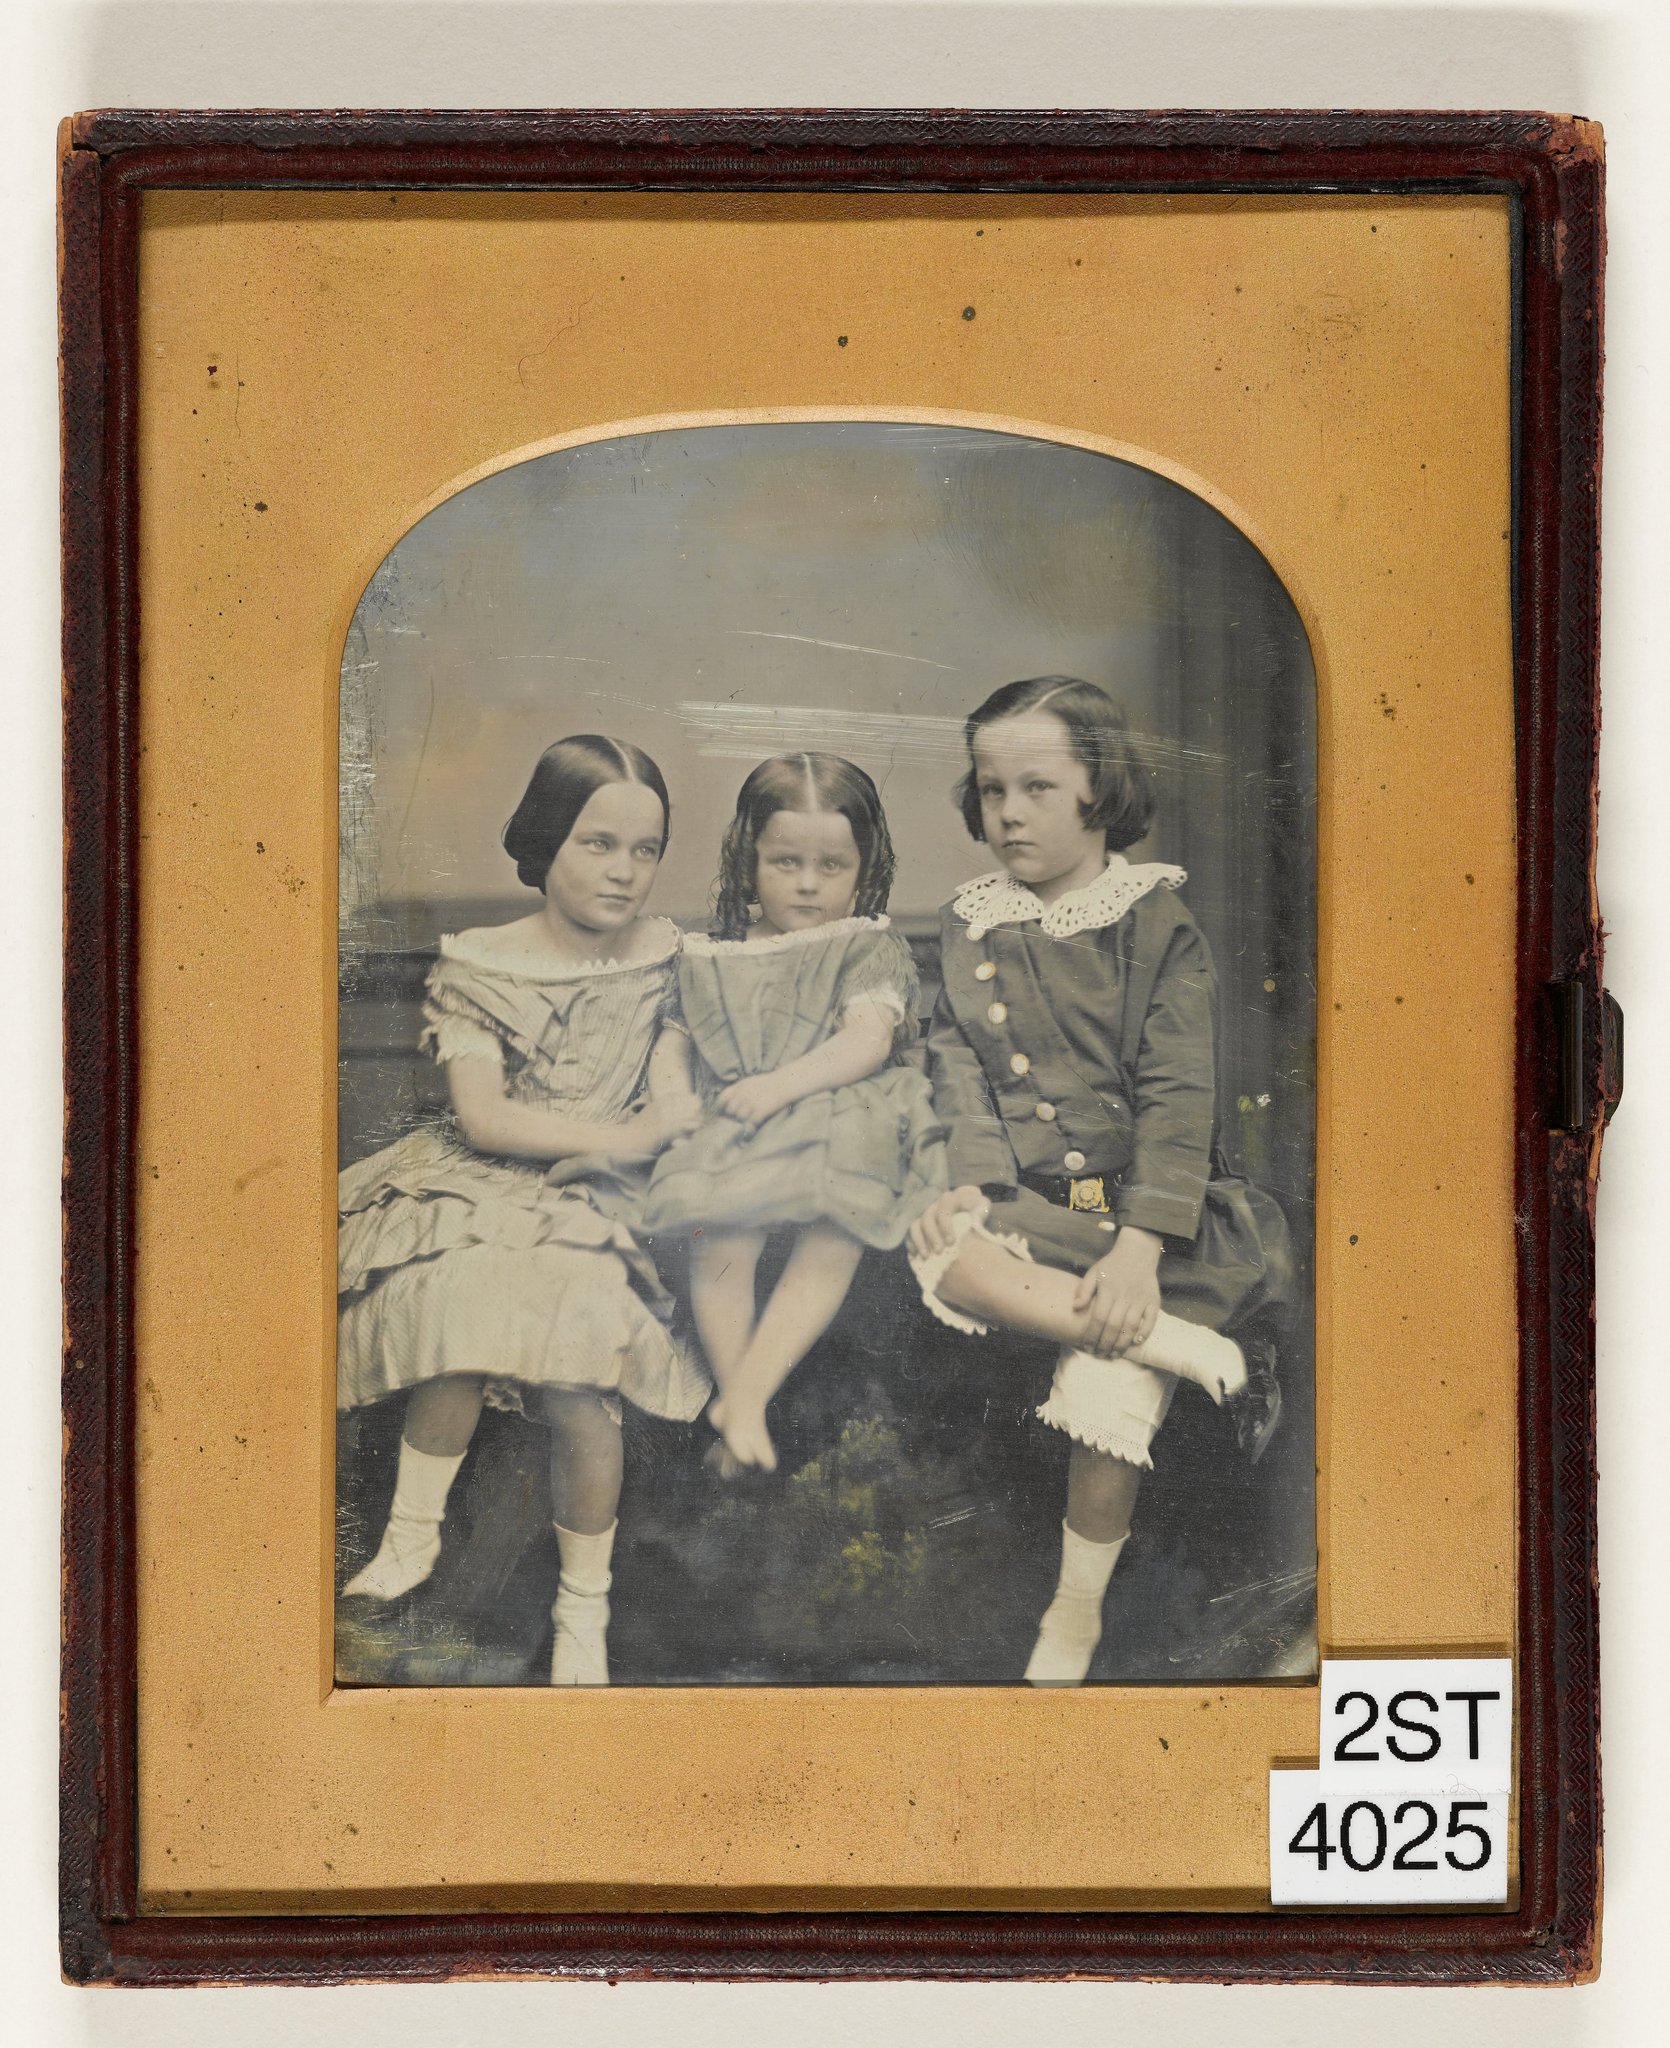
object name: photograph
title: Portret van drie kinderen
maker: john jabez edwin mayall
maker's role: fotograaf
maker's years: 1813-1901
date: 1850-1865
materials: copper, glass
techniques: daguerreotype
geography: great britain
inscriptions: stamp: ‘224, REGENT ST / (ARGYLL PLACE) / MAYALL / & / 433, WEST STRAND’